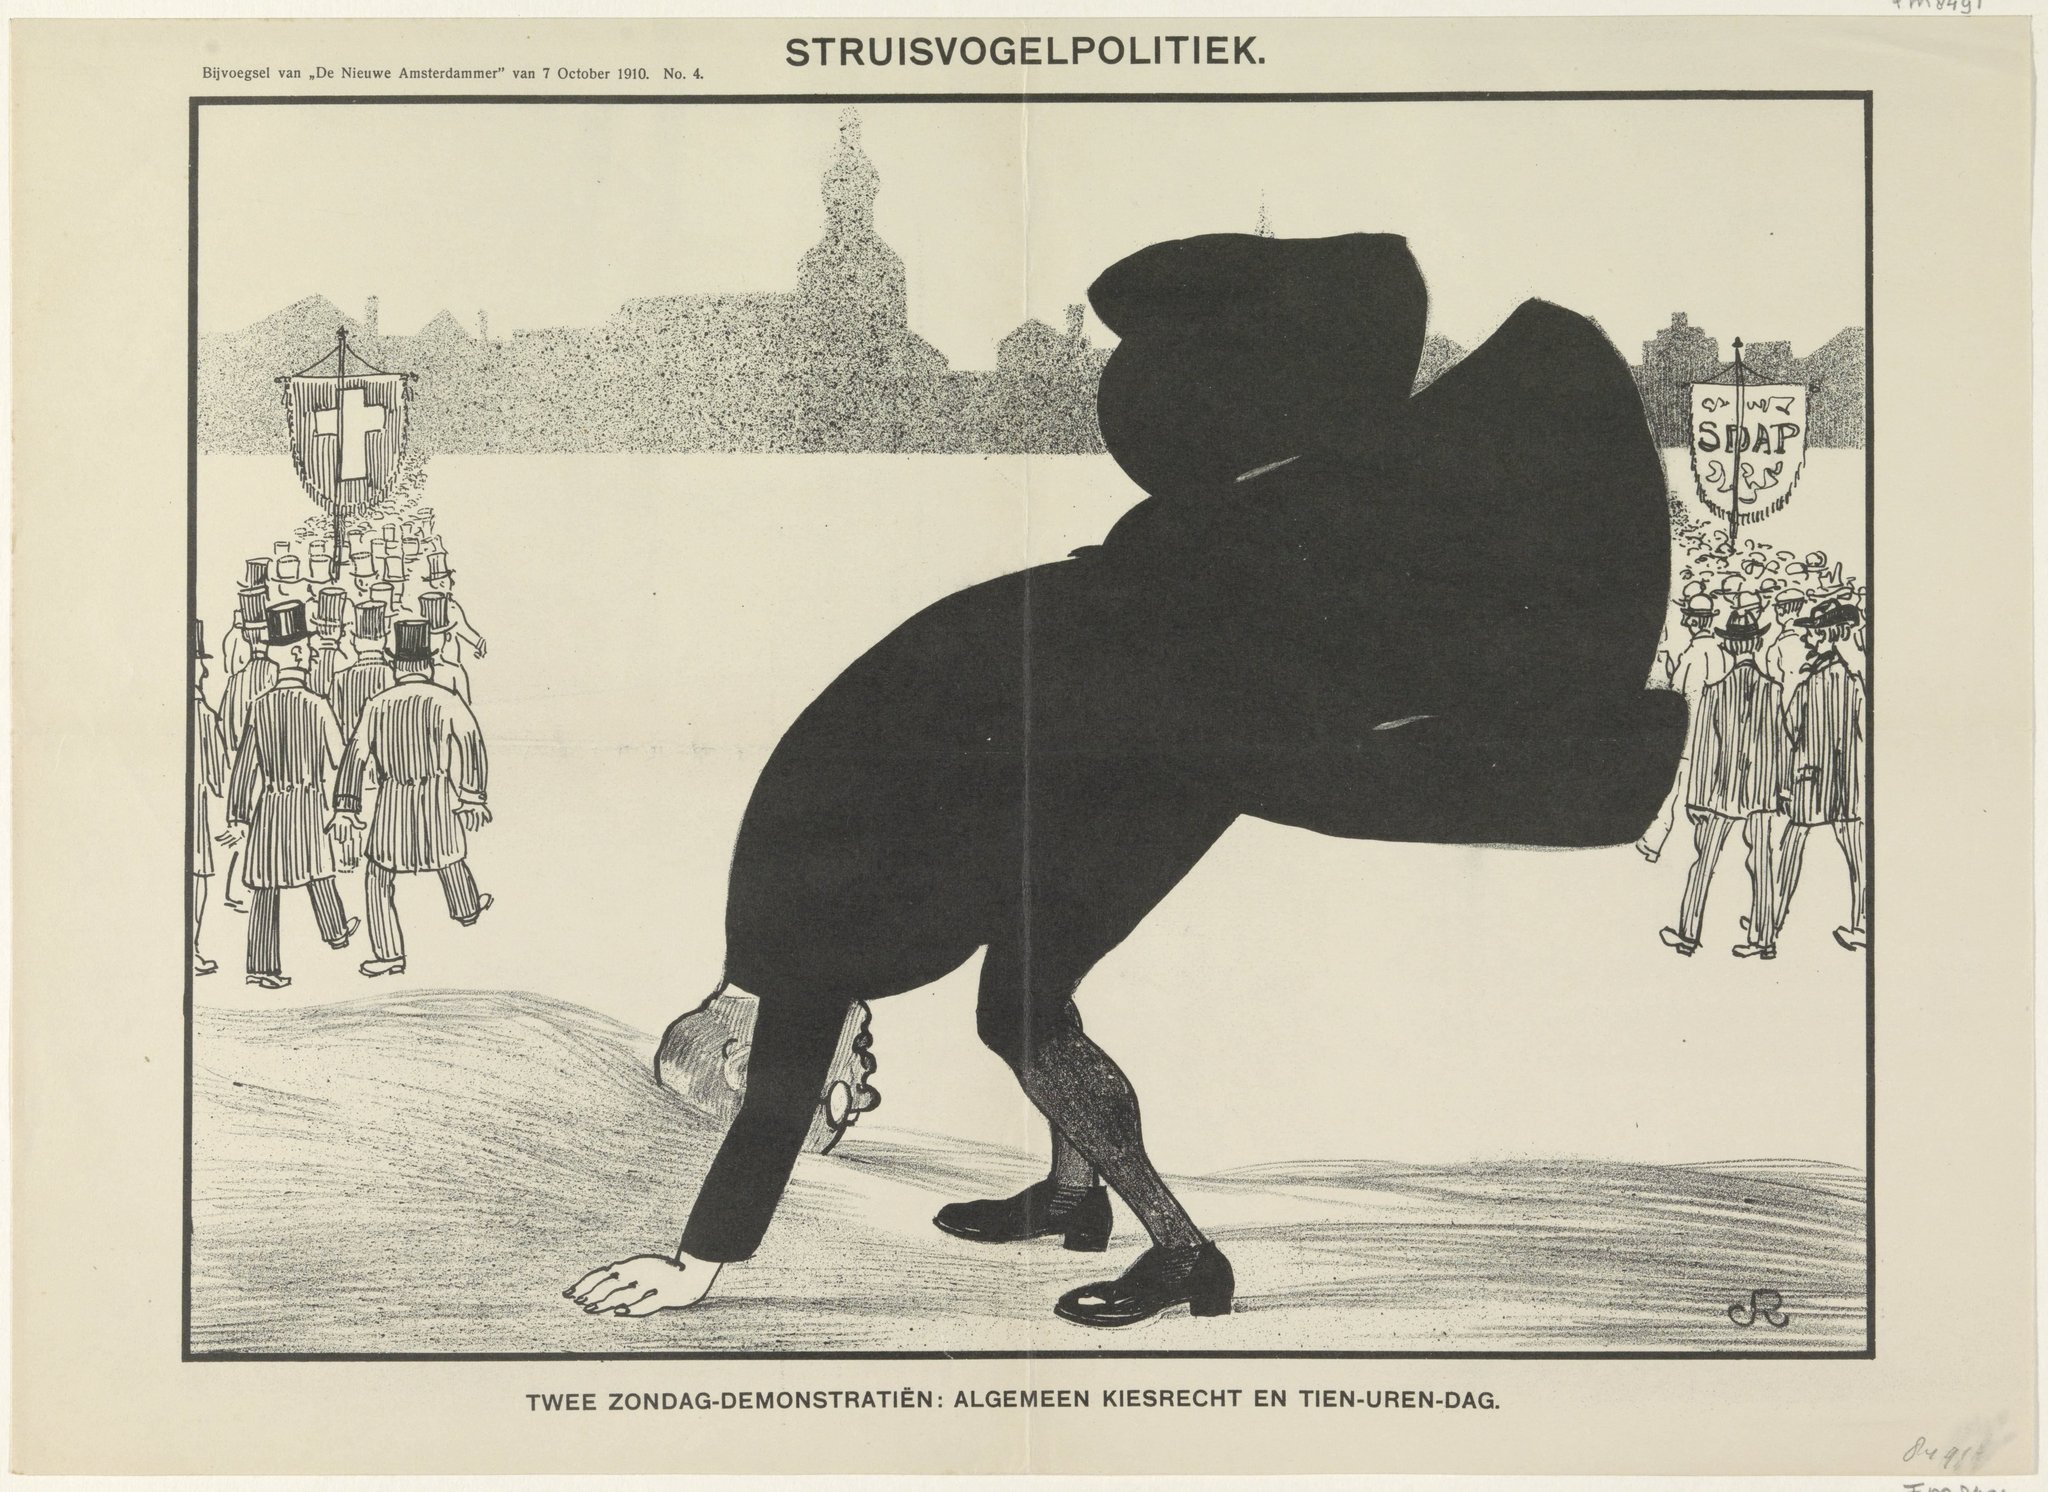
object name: print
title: Spotprent op twee politieke kwesties, 1910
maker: Anonymous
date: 1910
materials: paper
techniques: lithograph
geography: netherlands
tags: political demonstration, political parties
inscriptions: collector's mark: Lugt 2228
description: Spotprent op twee politieke kwesties: het algemeen kiesrecht en de tienurige werkdag. Een politicus steekt zijn hoofd in het zand, op de achtergrond twee politieke demonstraties van de christelijke partijen en de SDAP. Verschenen als bijvoegsel van de Nieuwe Amsterdammer van 7 oktober 1910, no. 4.